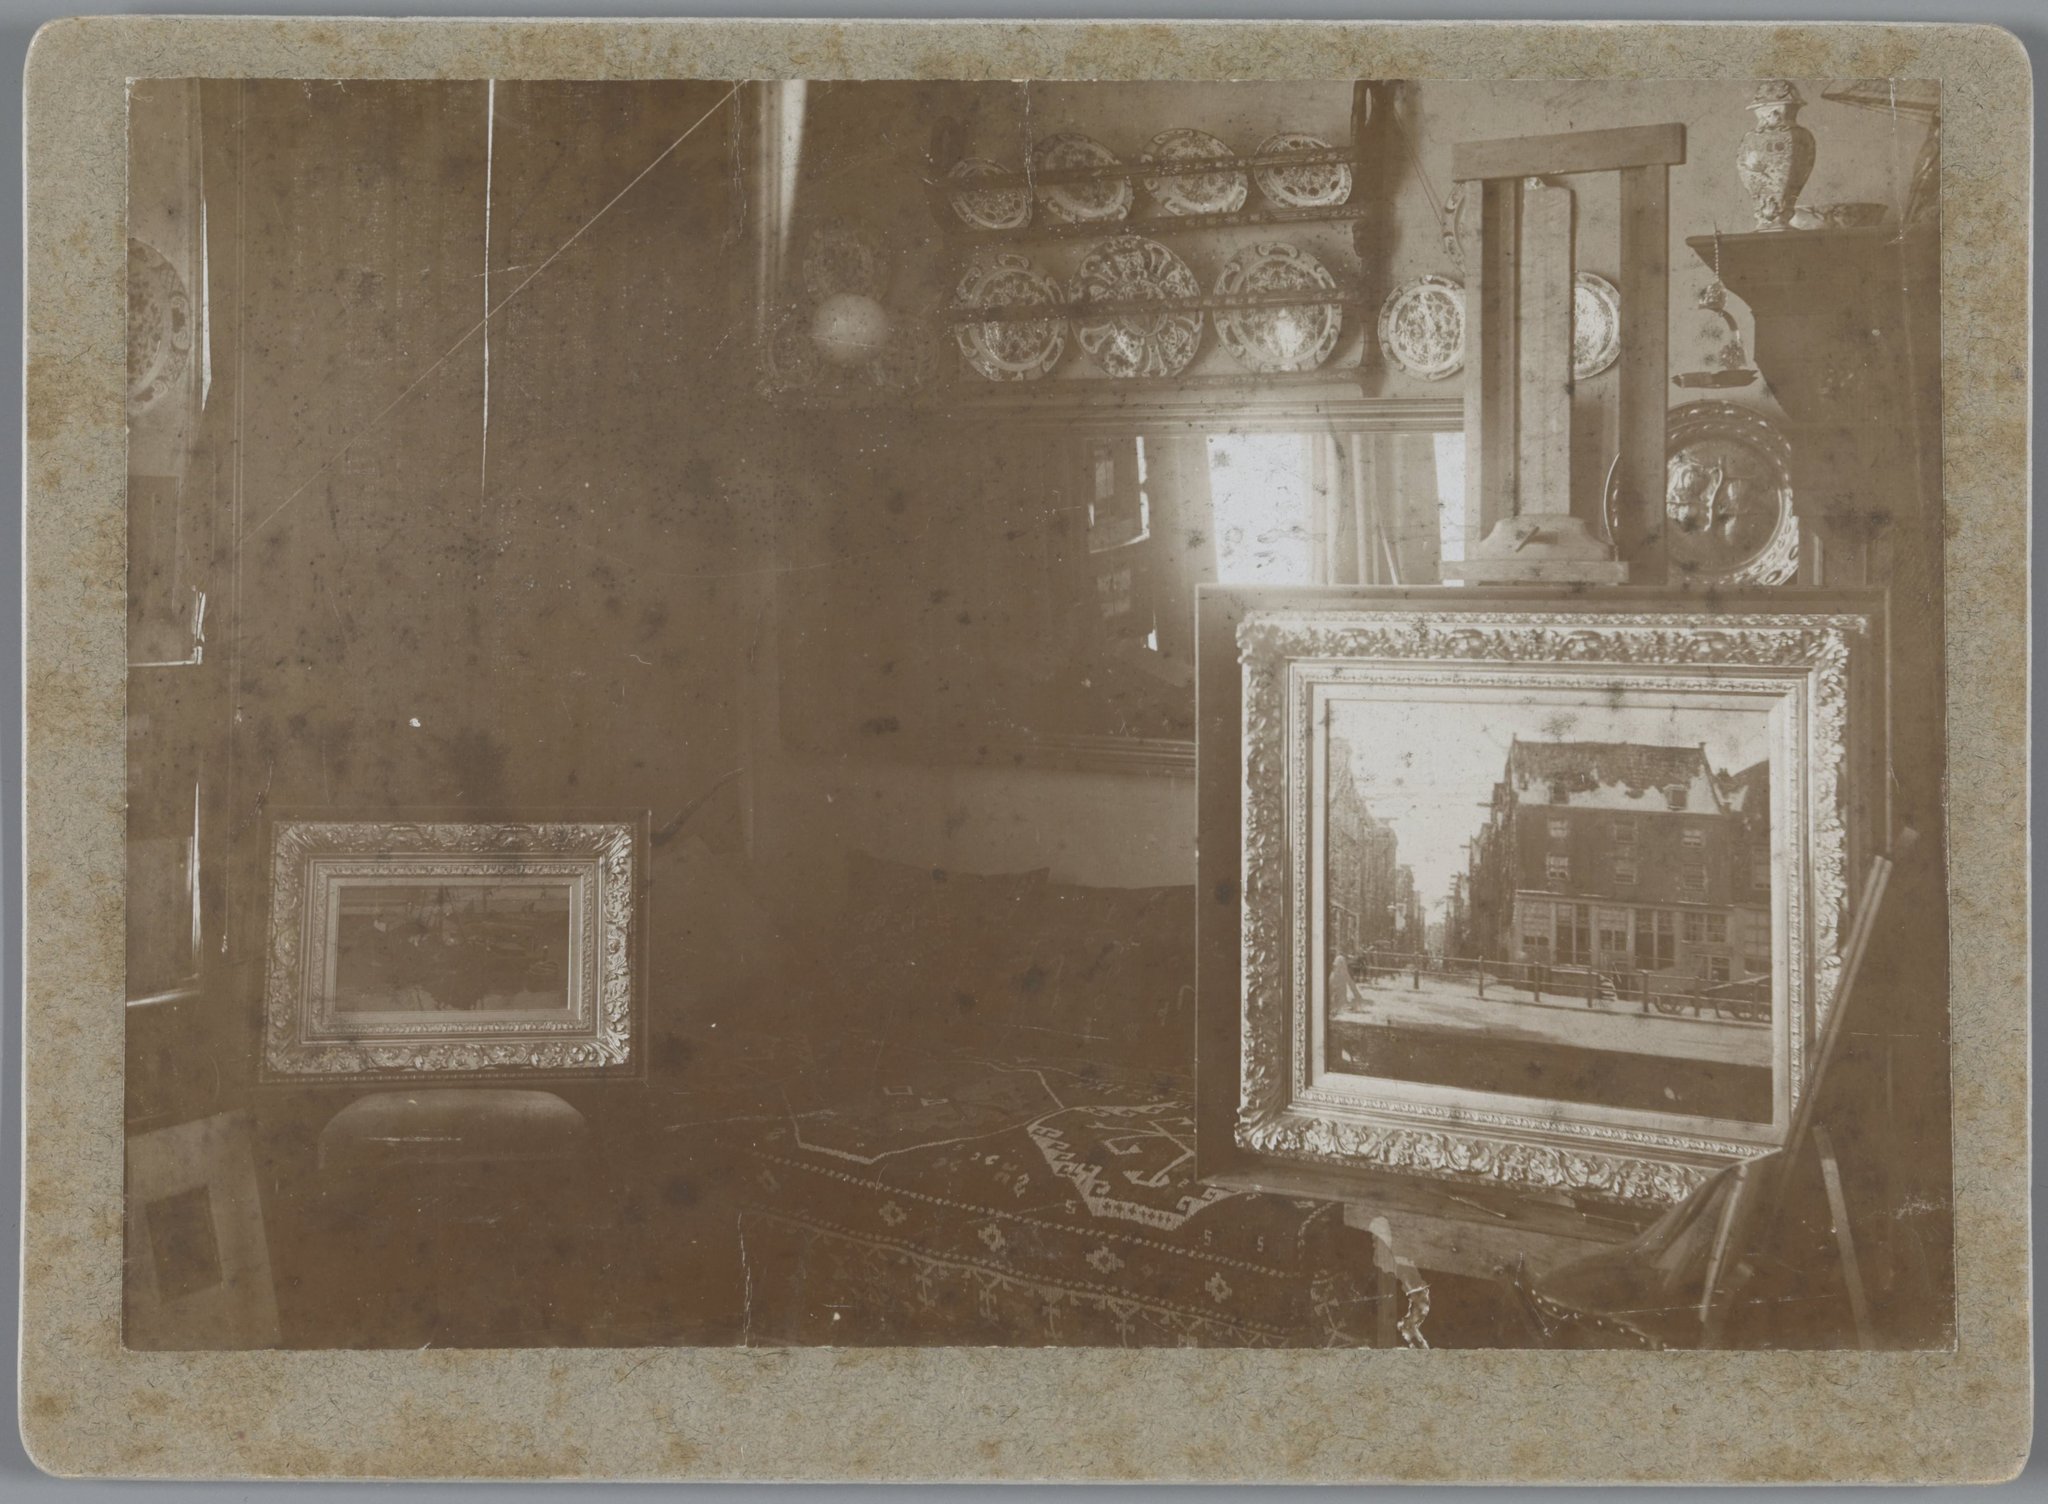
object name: photograph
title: Atelier Witsen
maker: willem witsen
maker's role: draughtsman, painter, print maker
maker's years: 1860-1923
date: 1860-1915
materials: cardboard, paper, photographic support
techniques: gelatin silver print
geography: amsterdam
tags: witsenhuis